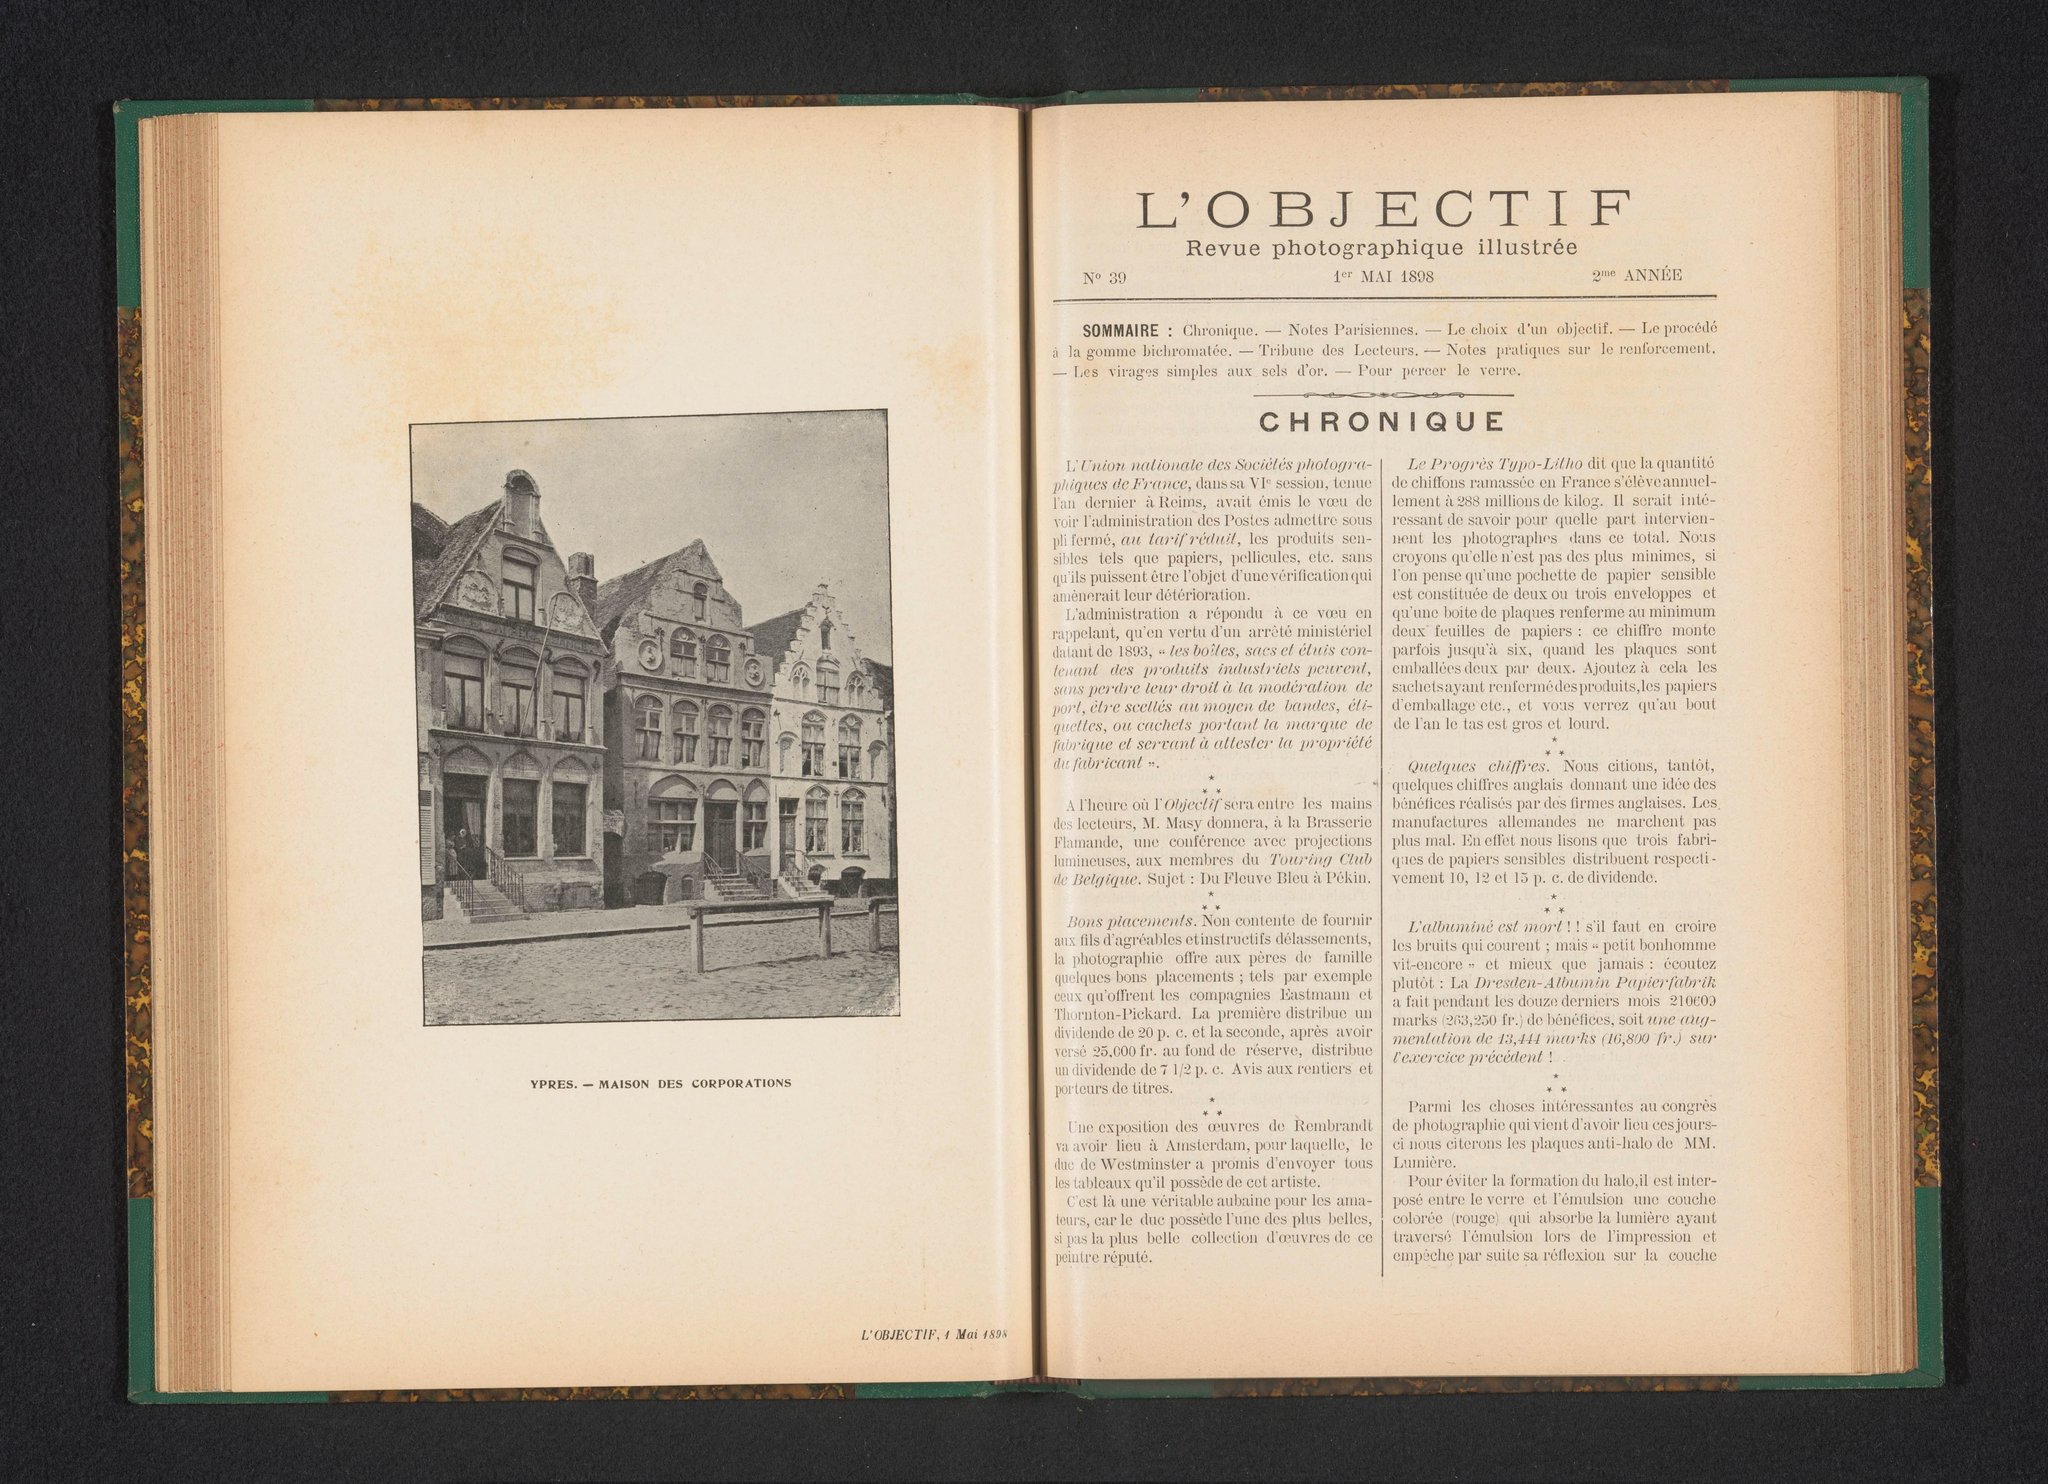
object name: page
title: Ypres. Maison des corporations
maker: jean malvaux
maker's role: printer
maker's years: 1839-1903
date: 1896-1900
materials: paper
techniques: autotype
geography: ieper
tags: corporative organization, guild, façade (of house or building)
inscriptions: inscription: ‘L'objectif, 4 Mai 1898’